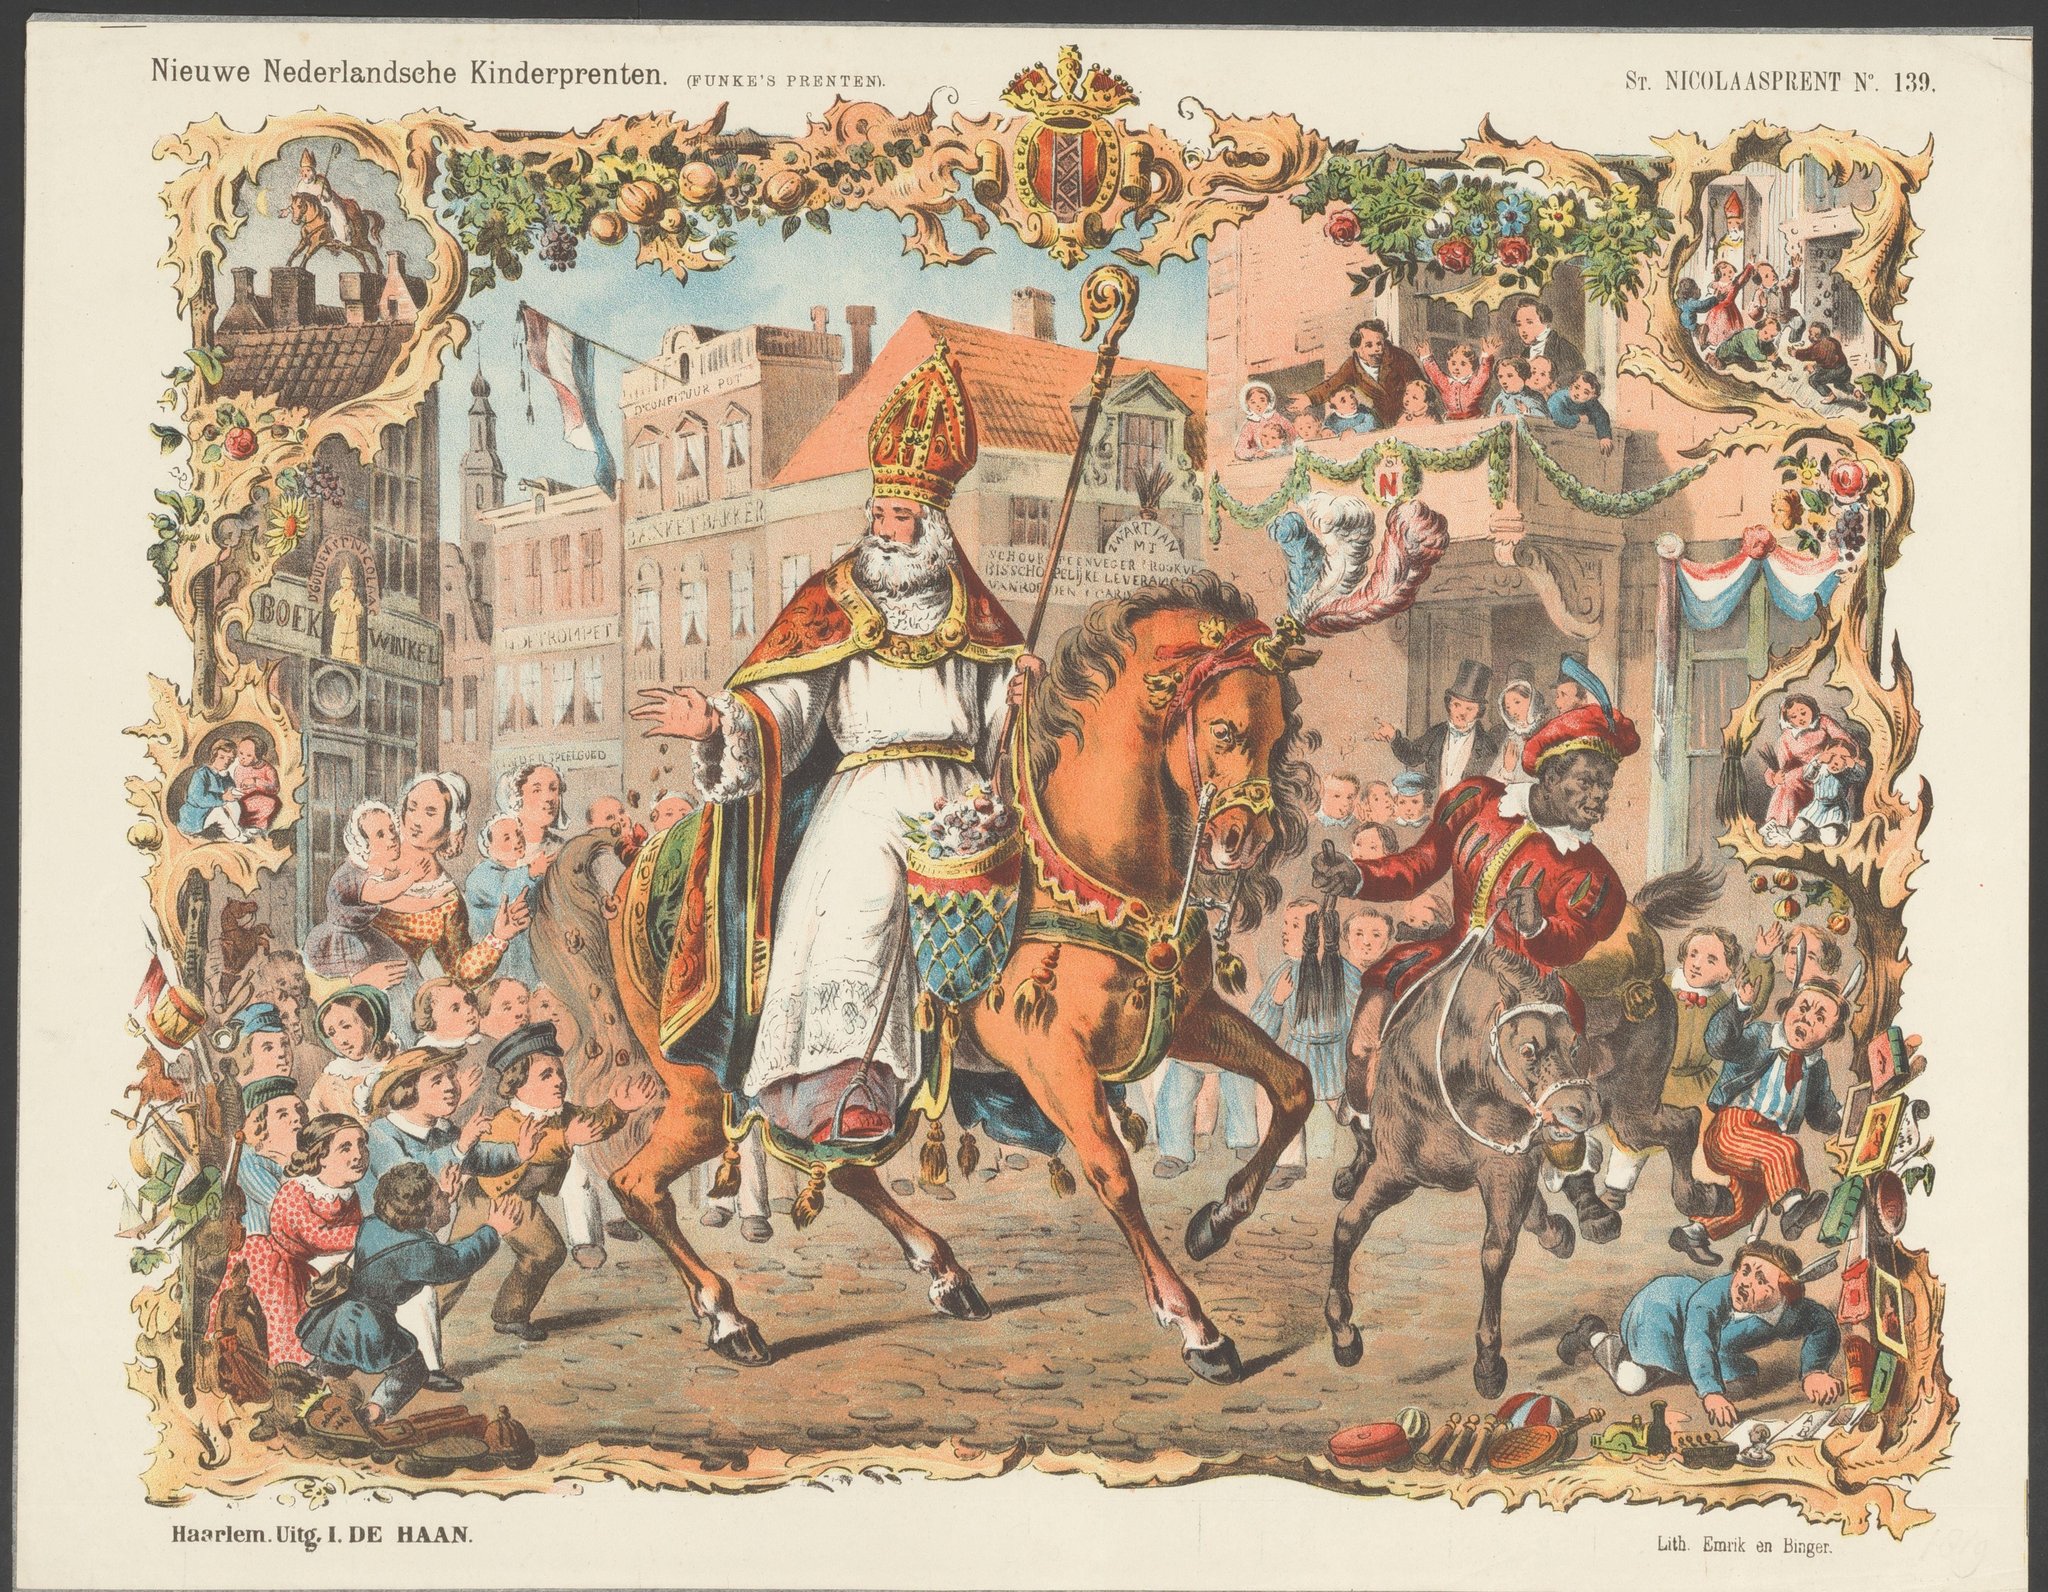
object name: print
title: Nieuwe Nederlandsche Kinderprenten (Funke's prenten)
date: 1871-1903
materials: paper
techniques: lithograph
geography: haarlem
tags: the bishop nicholas of myra (or bari); possible attributes: anchor, boat, three golden balls (on a book), three purses, three children in a tub, three maidens, festivities on st. nicholas (eve) (december 5)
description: Onderwerpsrubrieken binnen de Atlas Zeden en Gewoonten: Zeden en Gewoonten in Engeren Zin. Volksleven. Volksfeesten. St. Nicolaas.